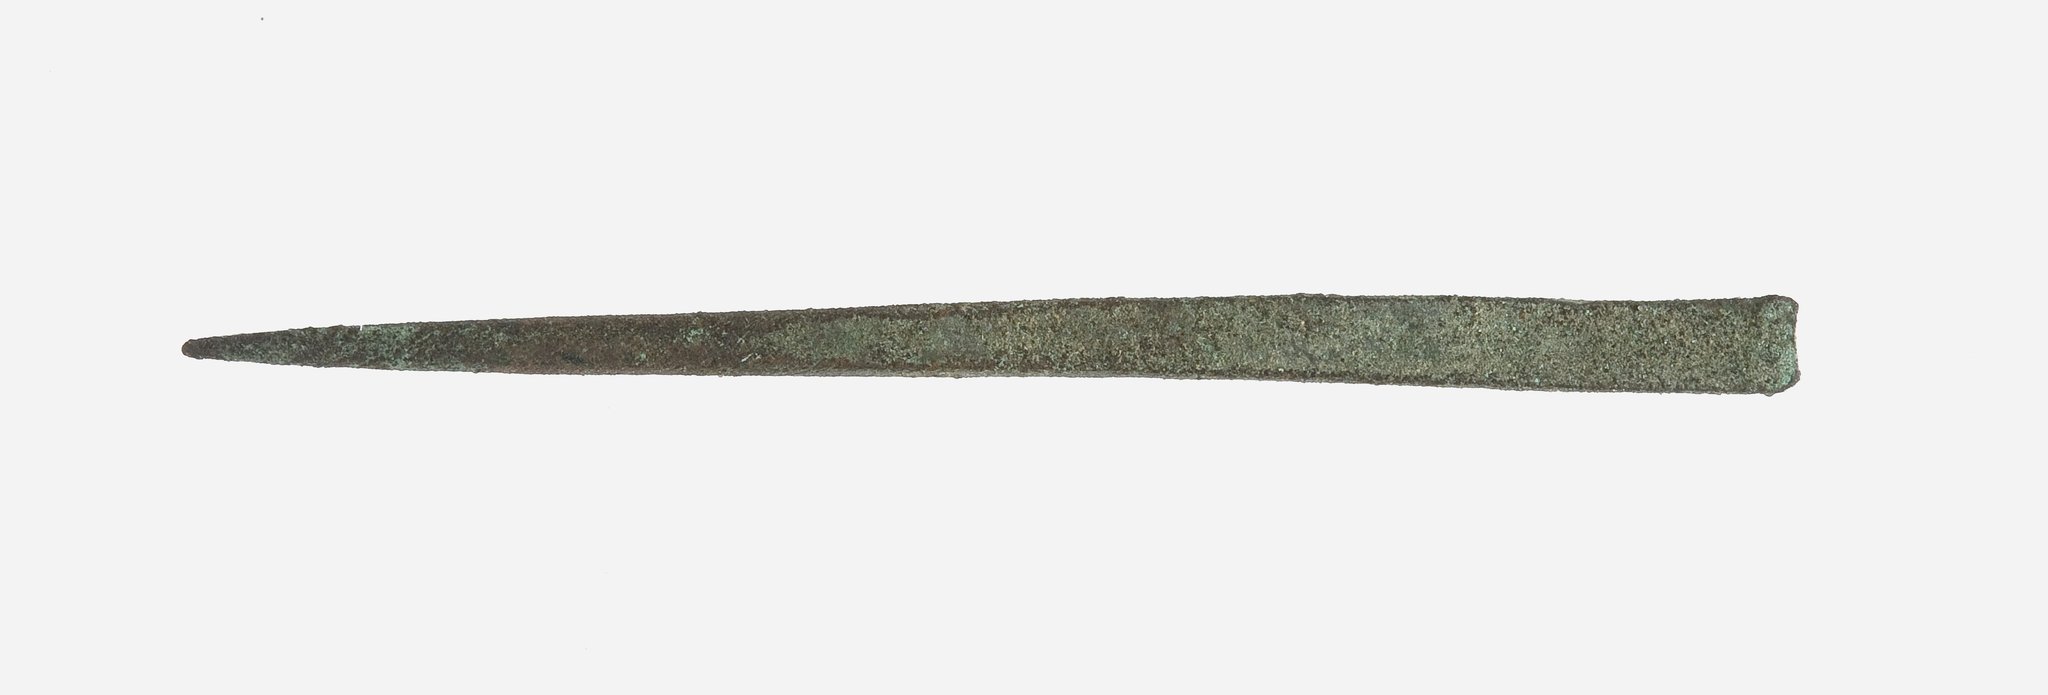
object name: awl, leatherwork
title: Leatherworker's Awl Point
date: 1390-1352 BCE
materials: bronze, copper alloy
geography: egypt